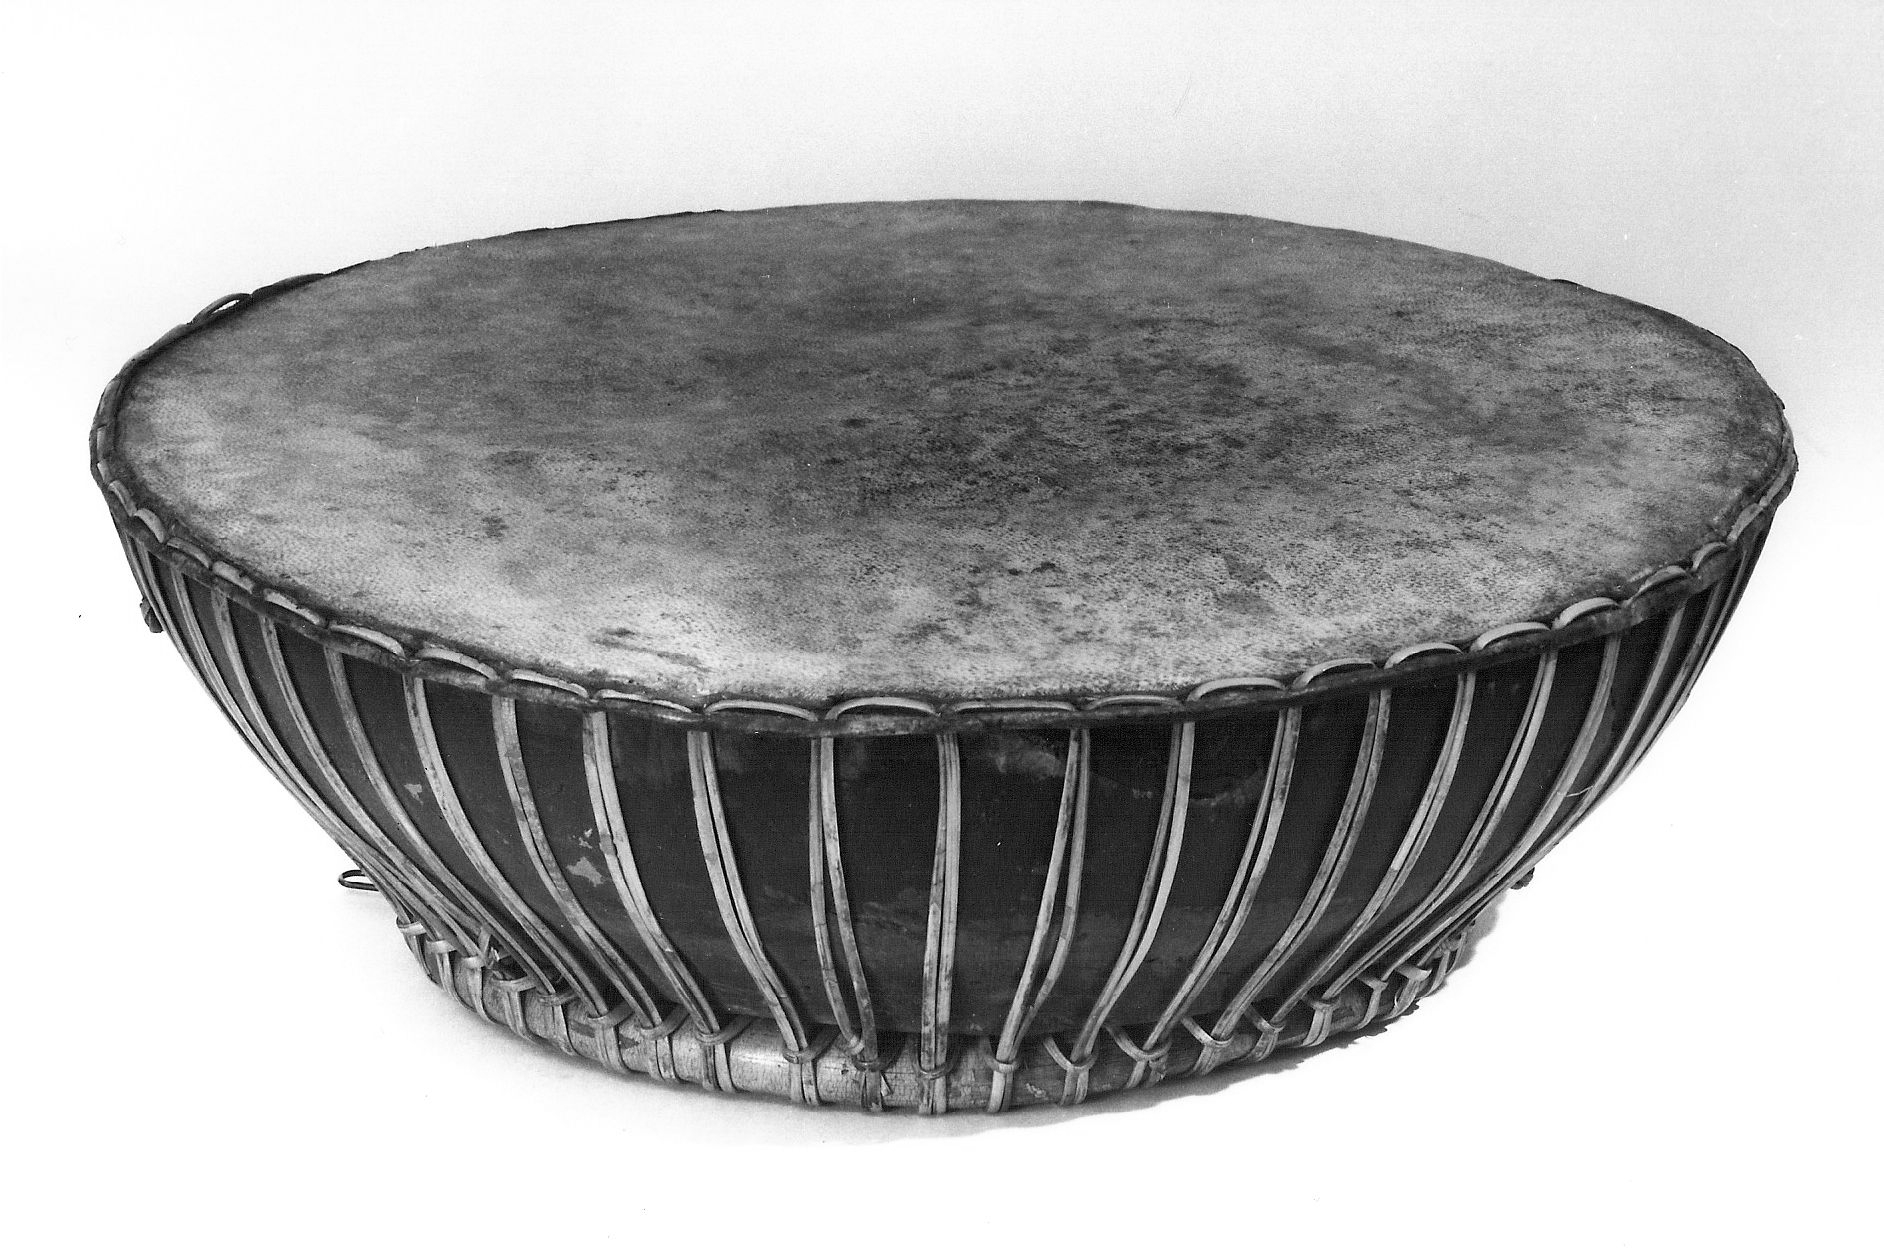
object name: drum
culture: malagasy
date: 1801-1900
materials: wood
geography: madagascar